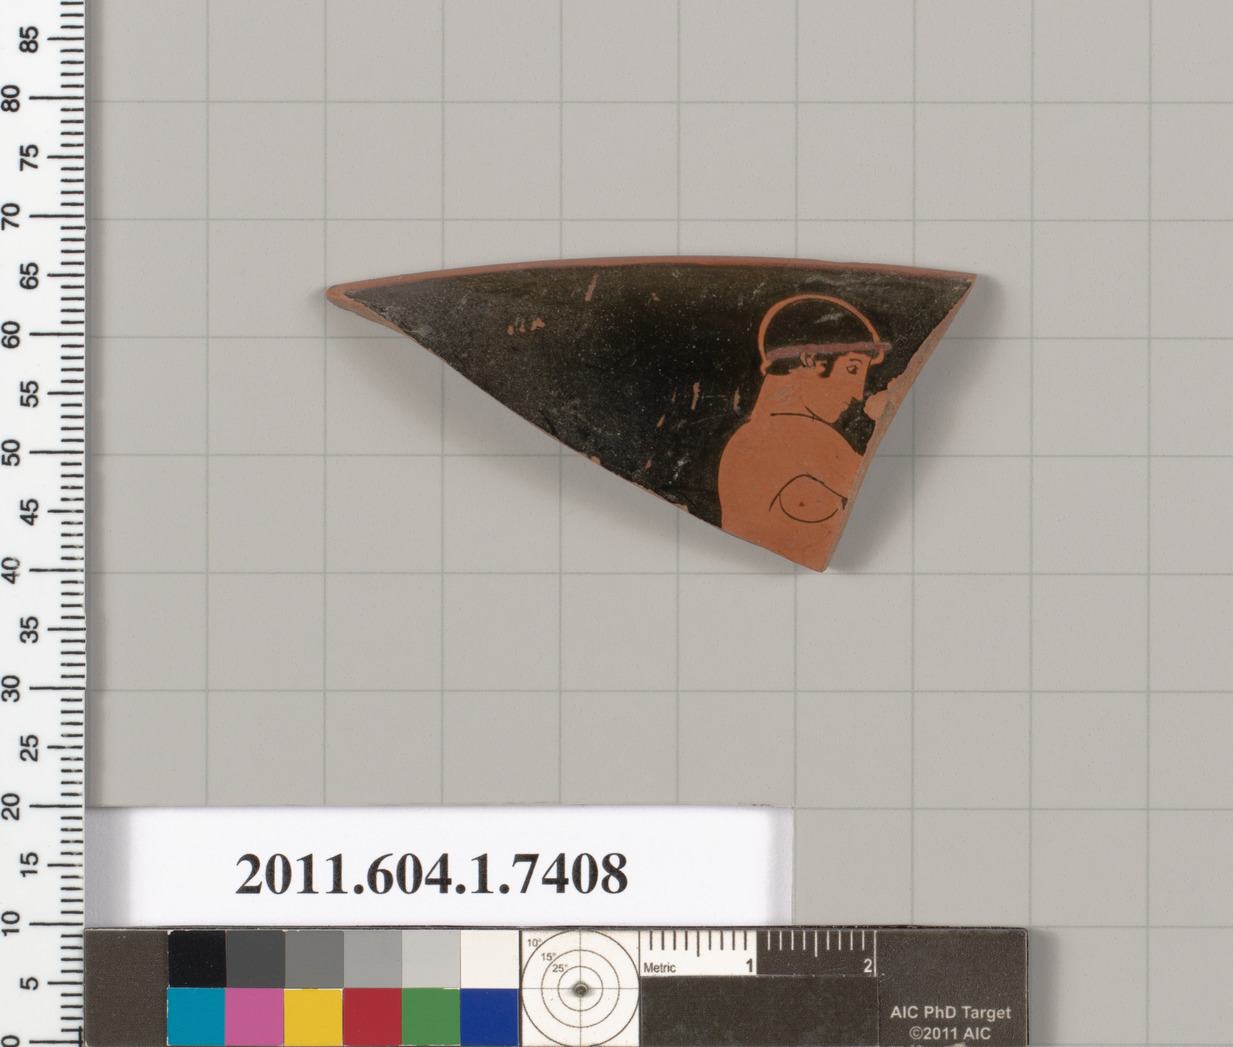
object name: kylix fragment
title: Terracotta rim fragment of a kylix (drinking cup)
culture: greek, attic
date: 490-470 BCE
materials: terracotta